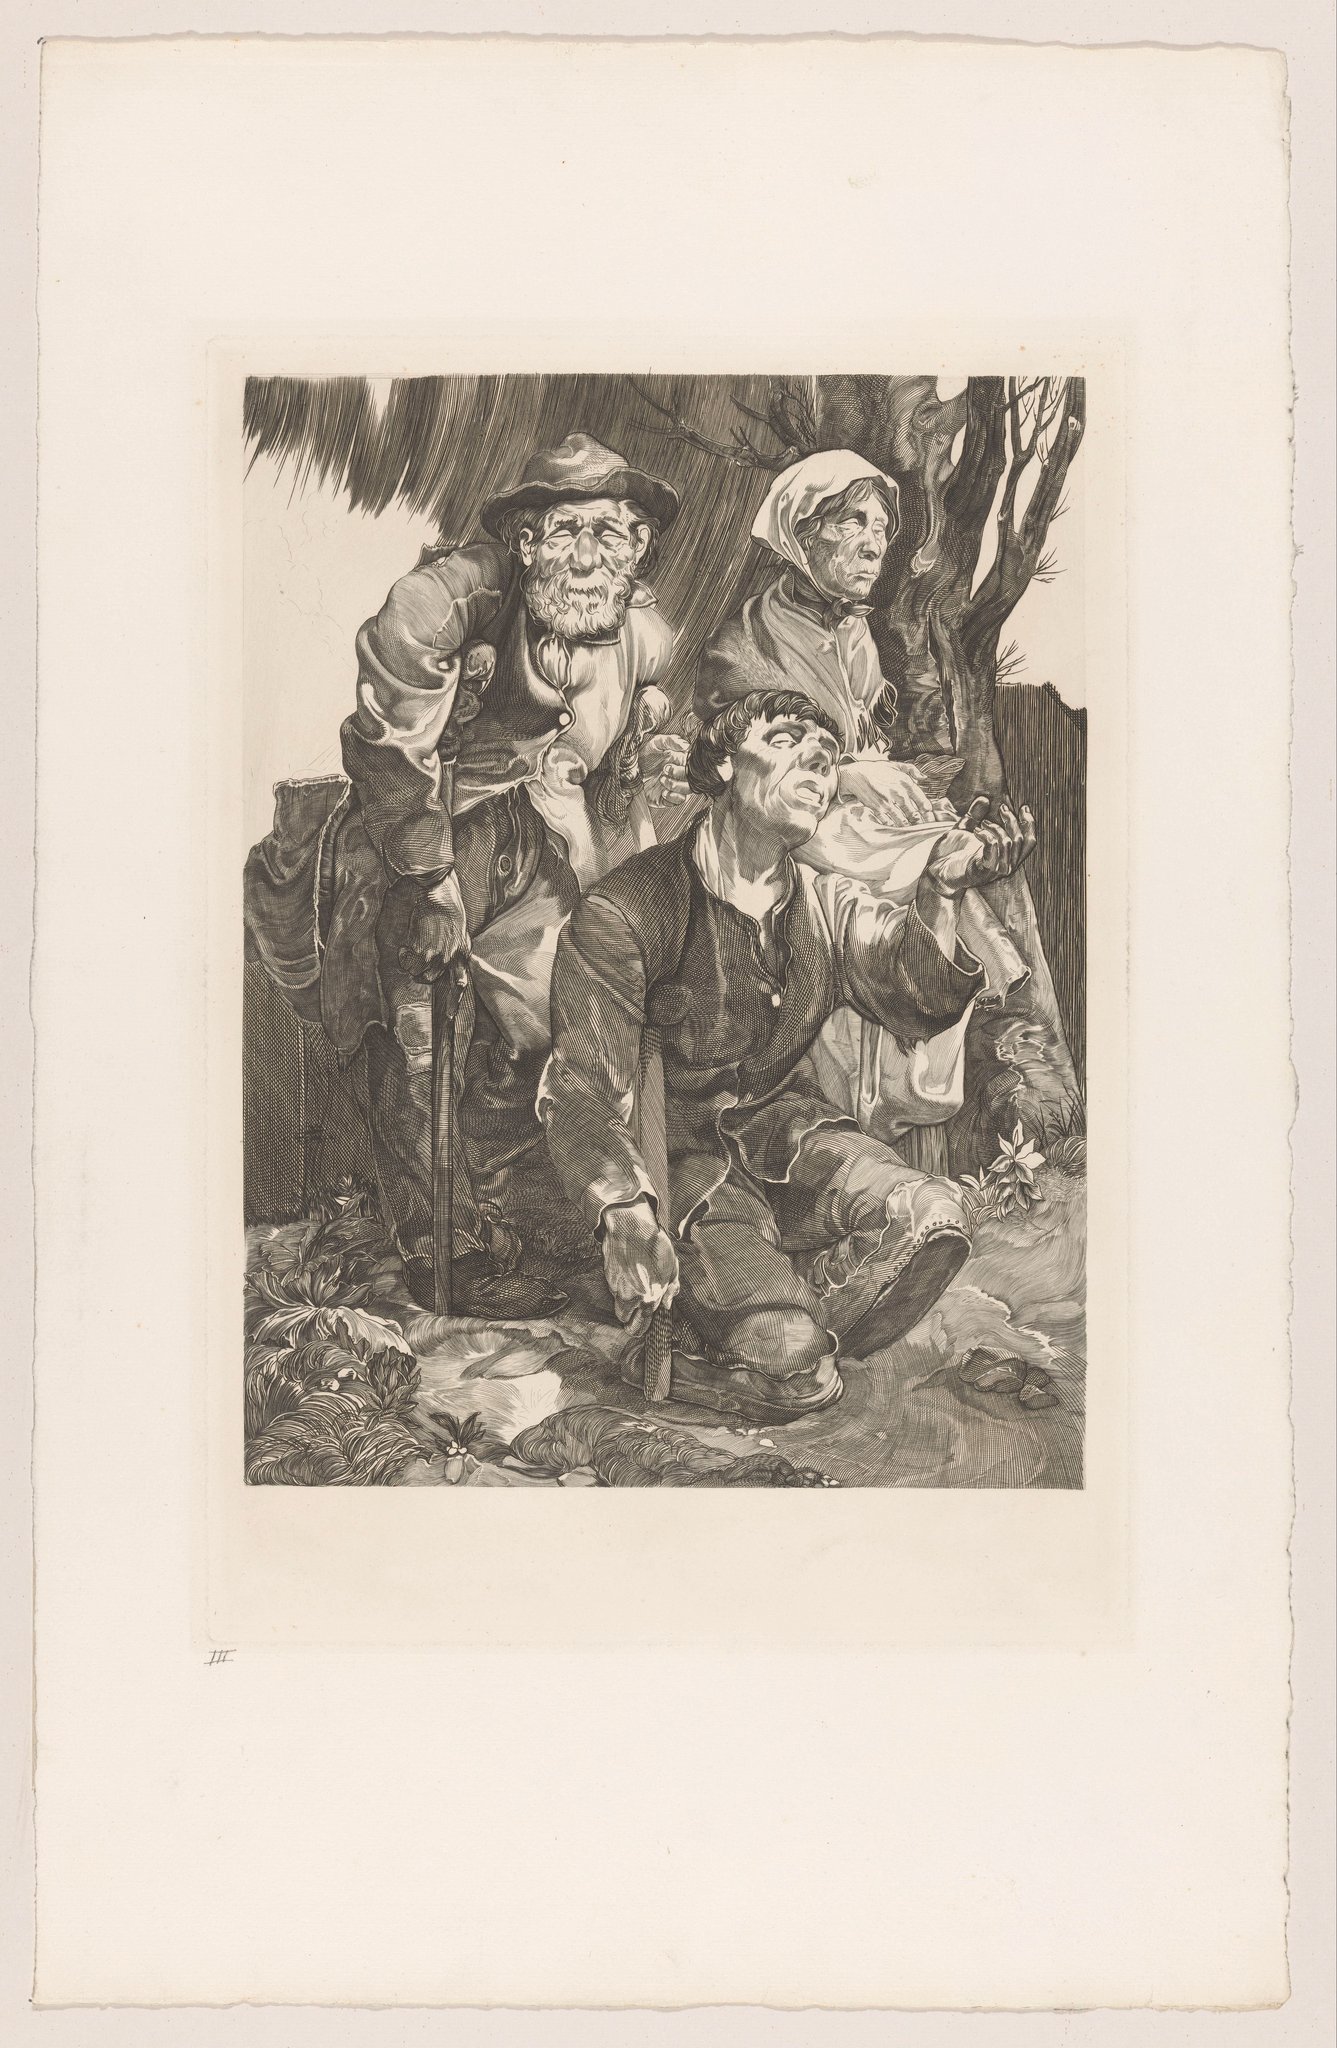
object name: print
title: Drie bedelaars bij een boom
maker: johannes josephus aarts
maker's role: draughtsman, print maker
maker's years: 1871-1934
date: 1881-1934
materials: paper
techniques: engraving, intaglio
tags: crutches, beggar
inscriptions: collector's mark: Lugt 2166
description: Twee mannen en vrouwen in her en der gescheurde kleding bij een boom. Zowel de staande als de zittende man ondersteunt zich met krukken. De zittende man houdt zijn hand op. De vrouw heeft een kleine rieten mand in haar hand.